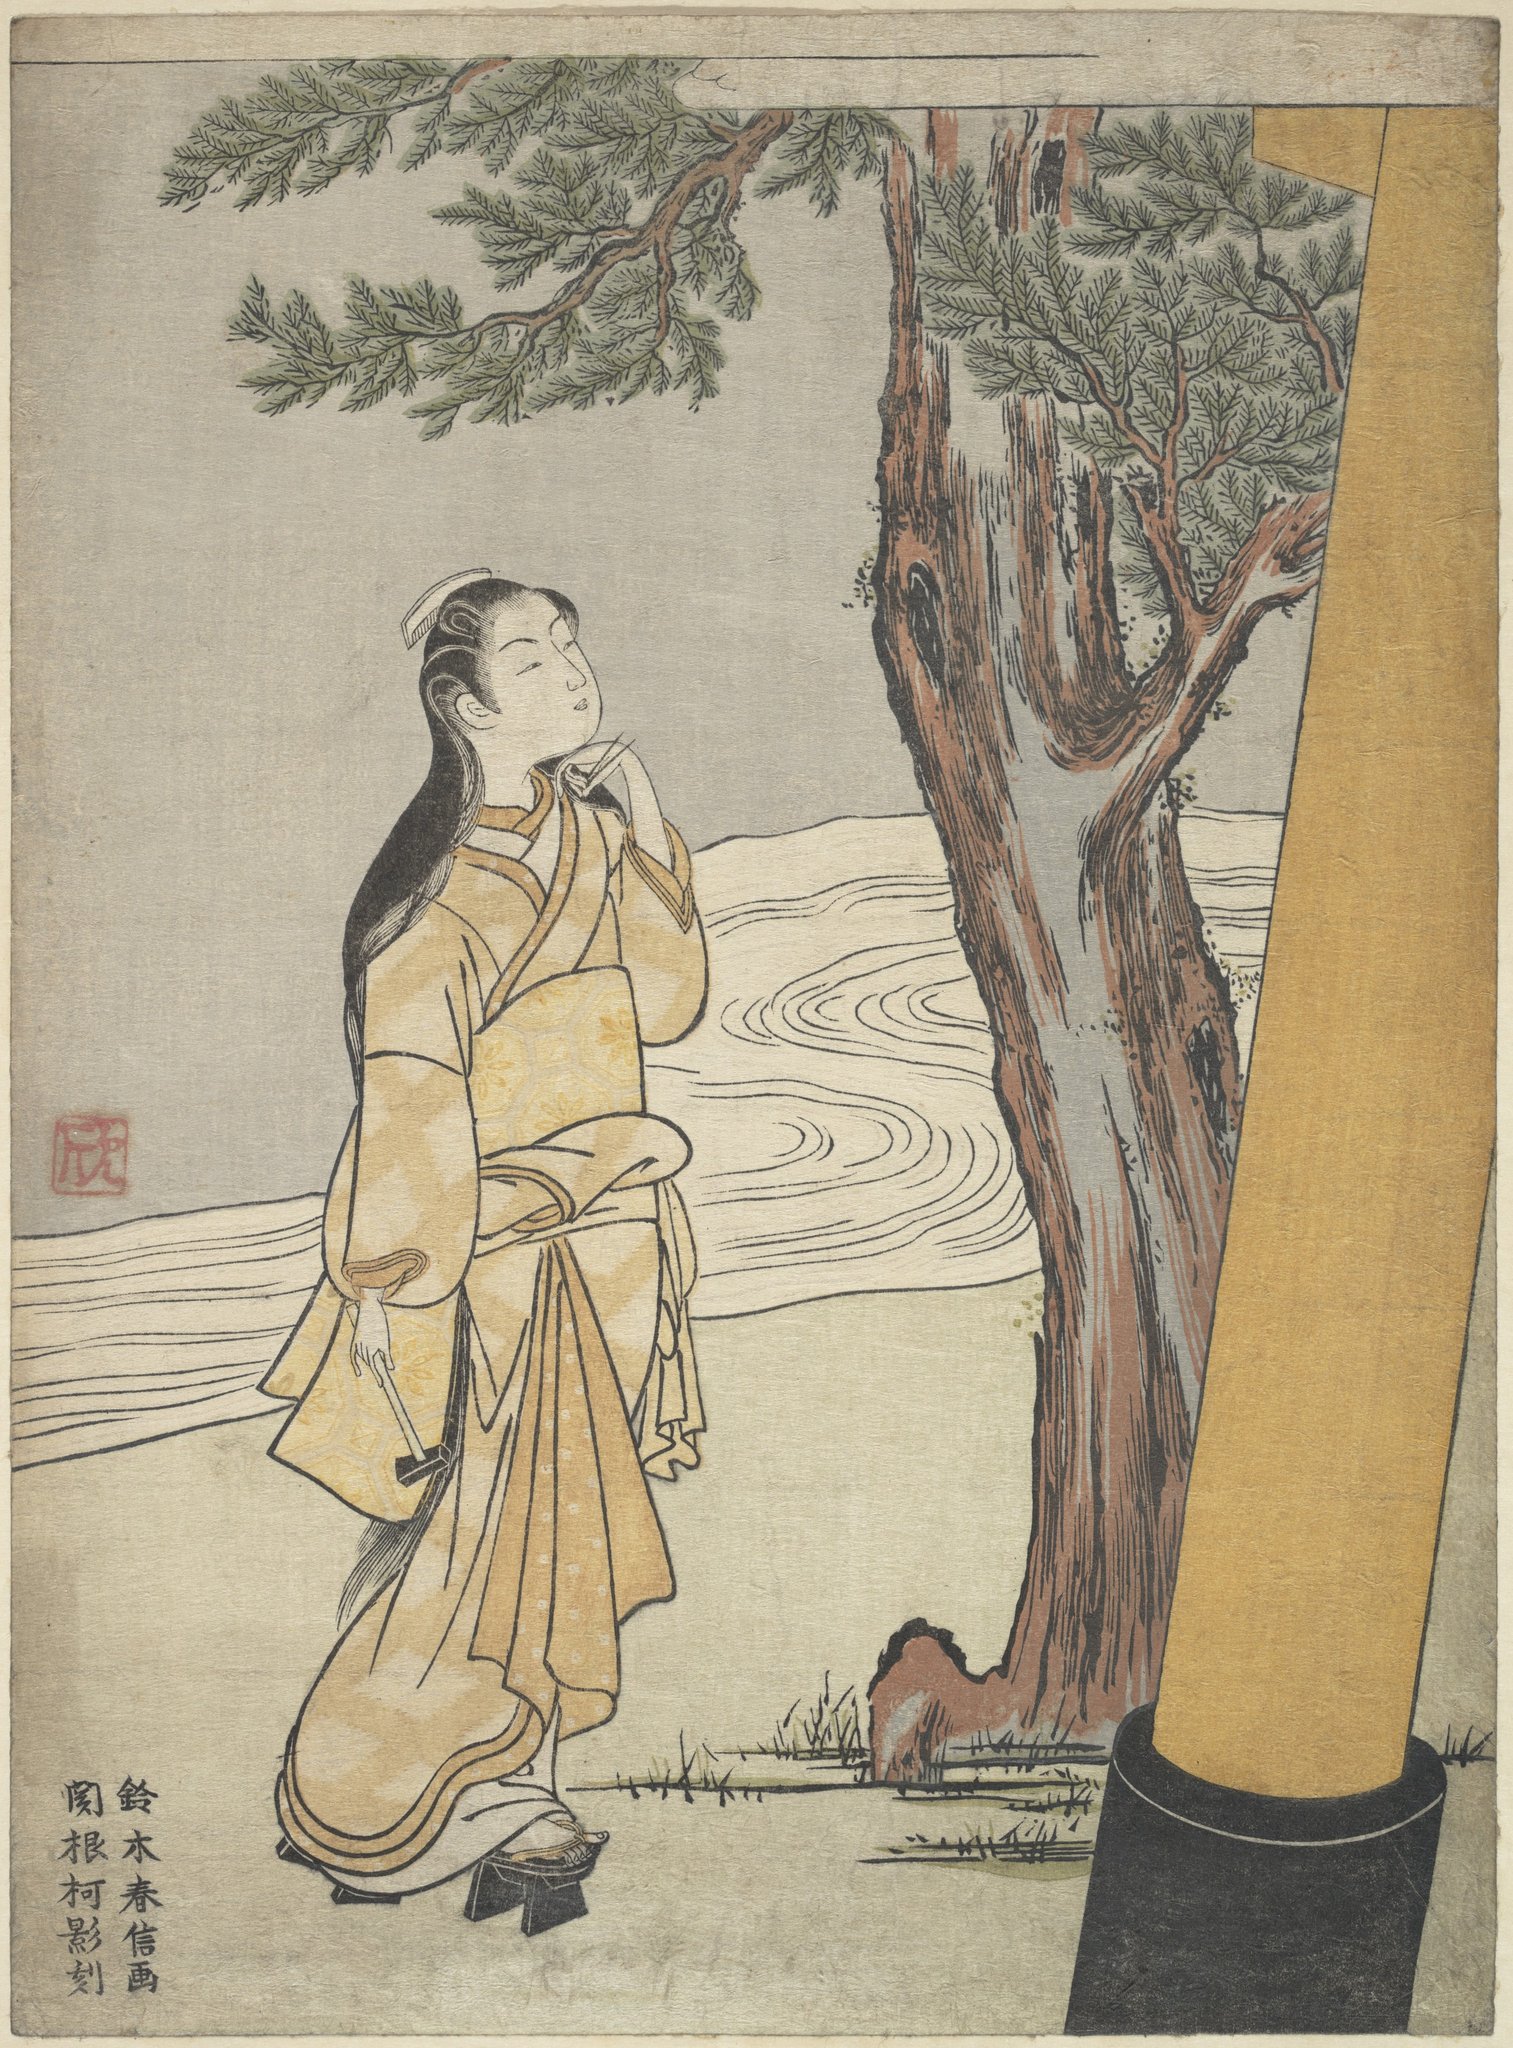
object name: print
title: Visit to a Shrine at the Hour of the Ox (Ushi no toki mairi)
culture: japanese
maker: suzuki harunobu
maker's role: artist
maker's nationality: japanese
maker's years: 1725-1770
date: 1765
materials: ink, paper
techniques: woodblock print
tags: women,trees,hammers